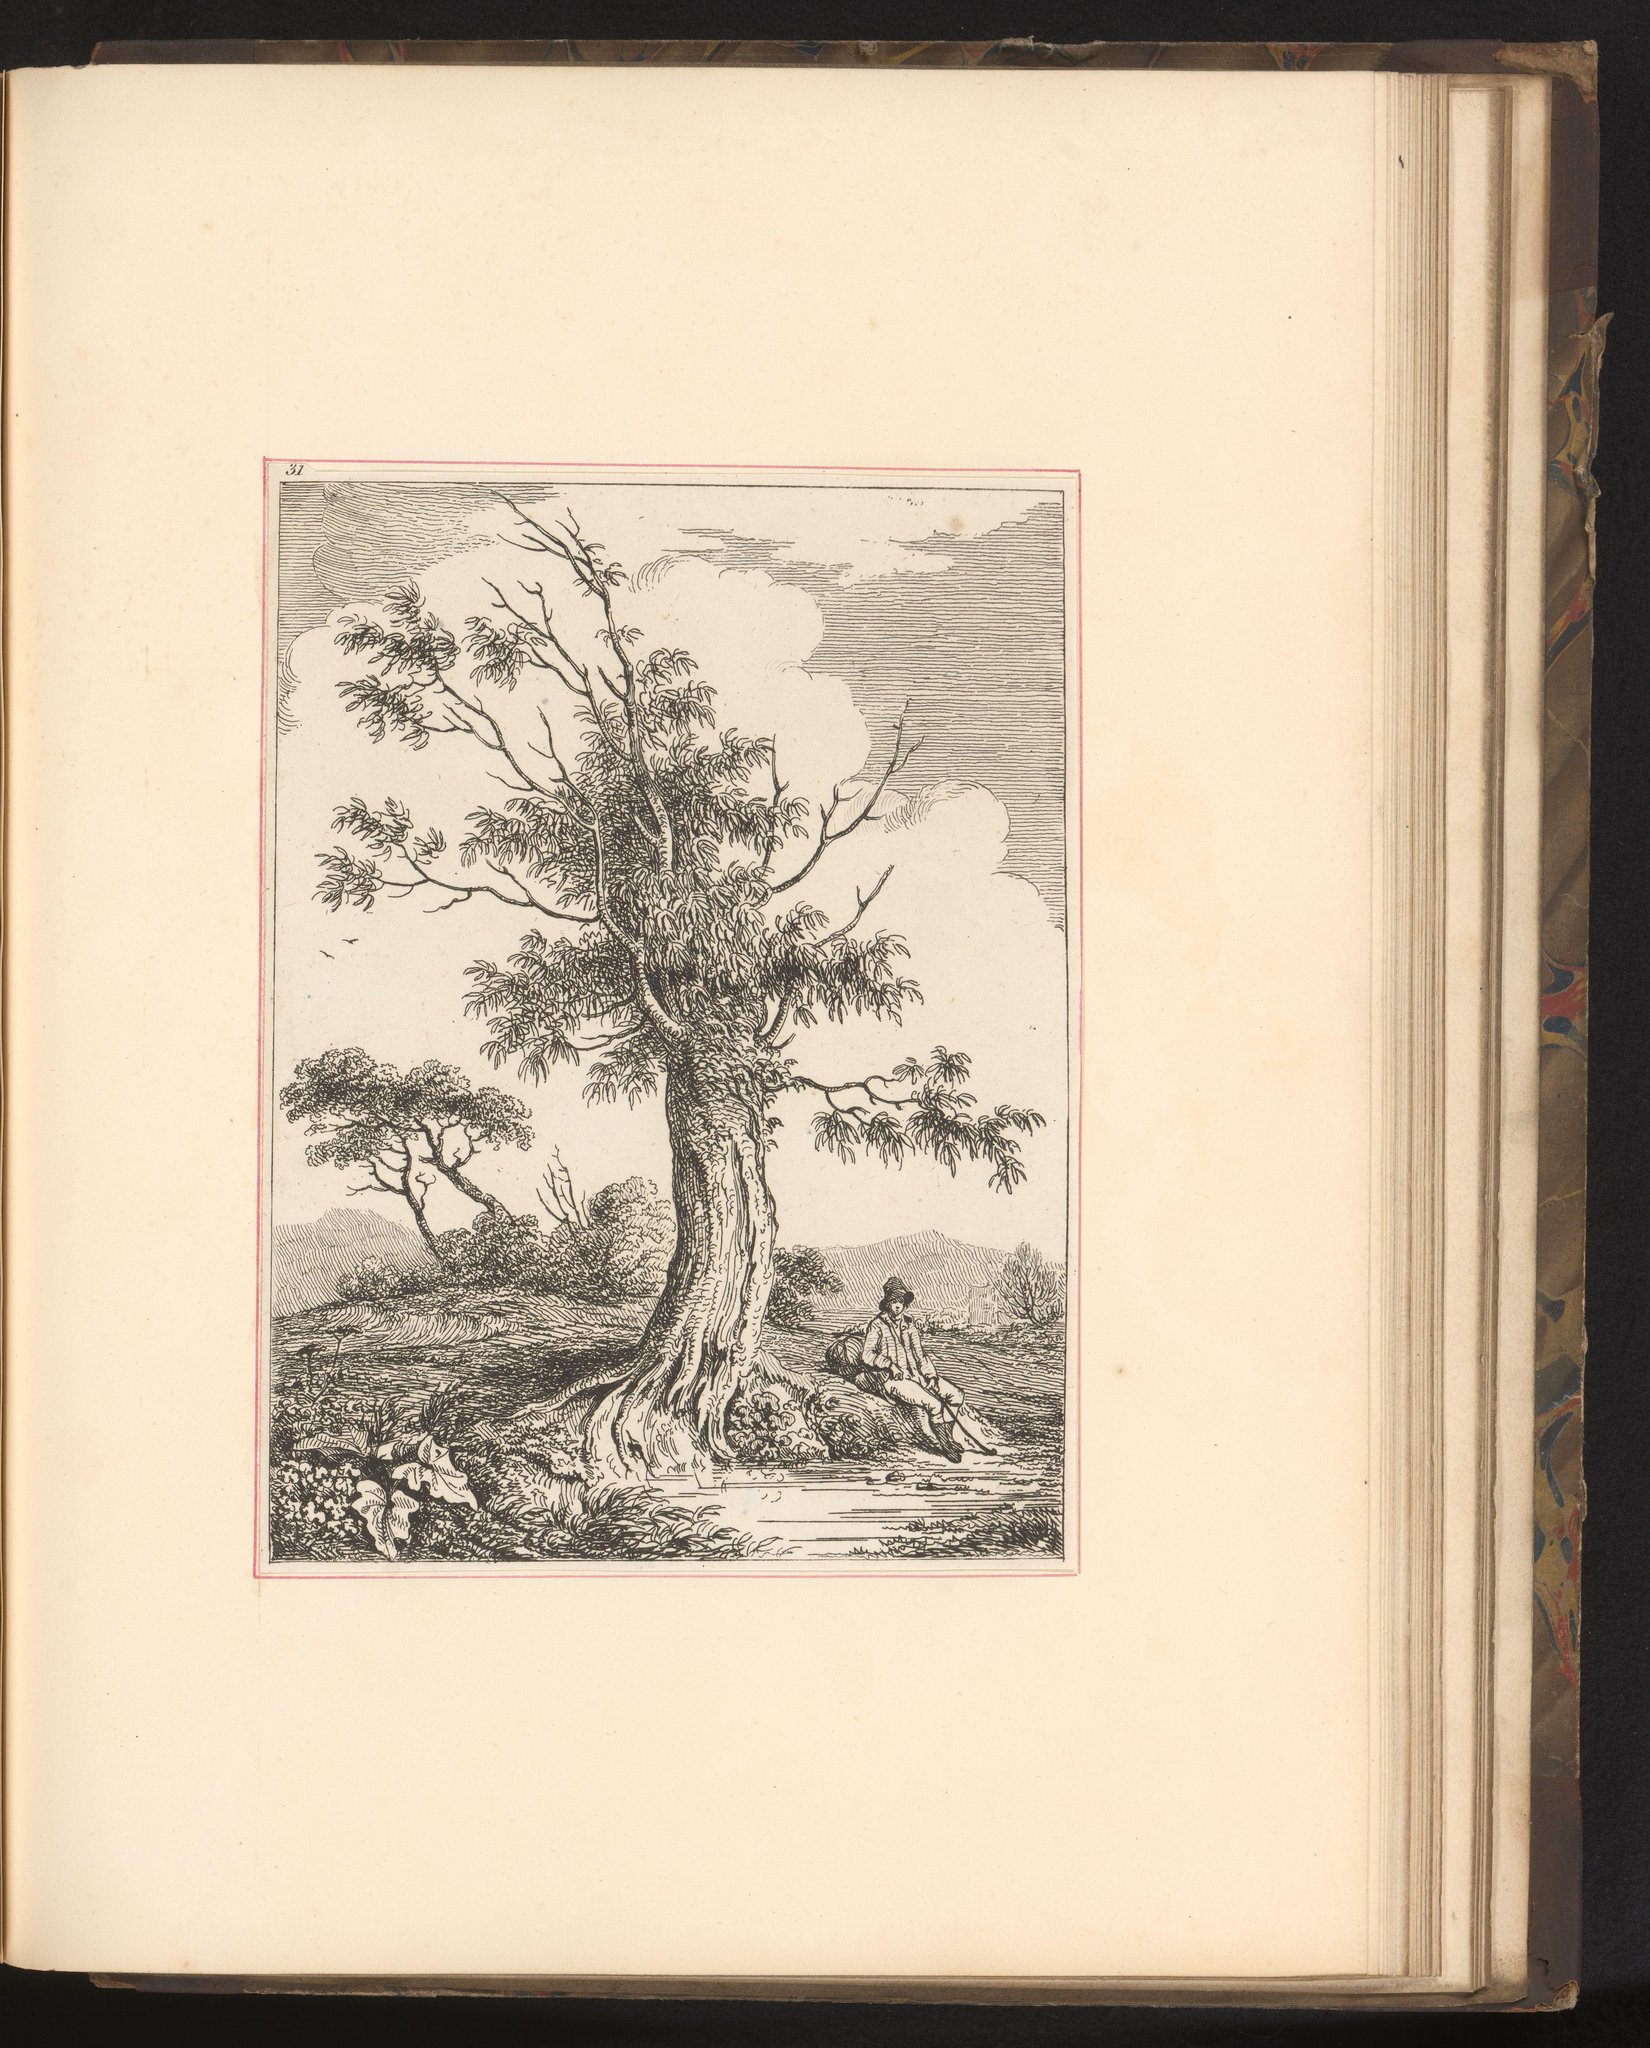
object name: print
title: Etsen door E. Edwards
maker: edward edwards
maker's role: painter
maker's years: 1738-1806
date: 1748-1806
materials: paper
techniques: etching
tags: (traveller) resting in the open air, landscapes (+ landscape with figures, staffage)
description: Prent maakt deel uit van een serie van 51 prenten, bestaande uit twee delen met landschappen (36 prenten) en figuren en portretten (15 prenten), voor het eerst uitgegeven in Londen in 1790.